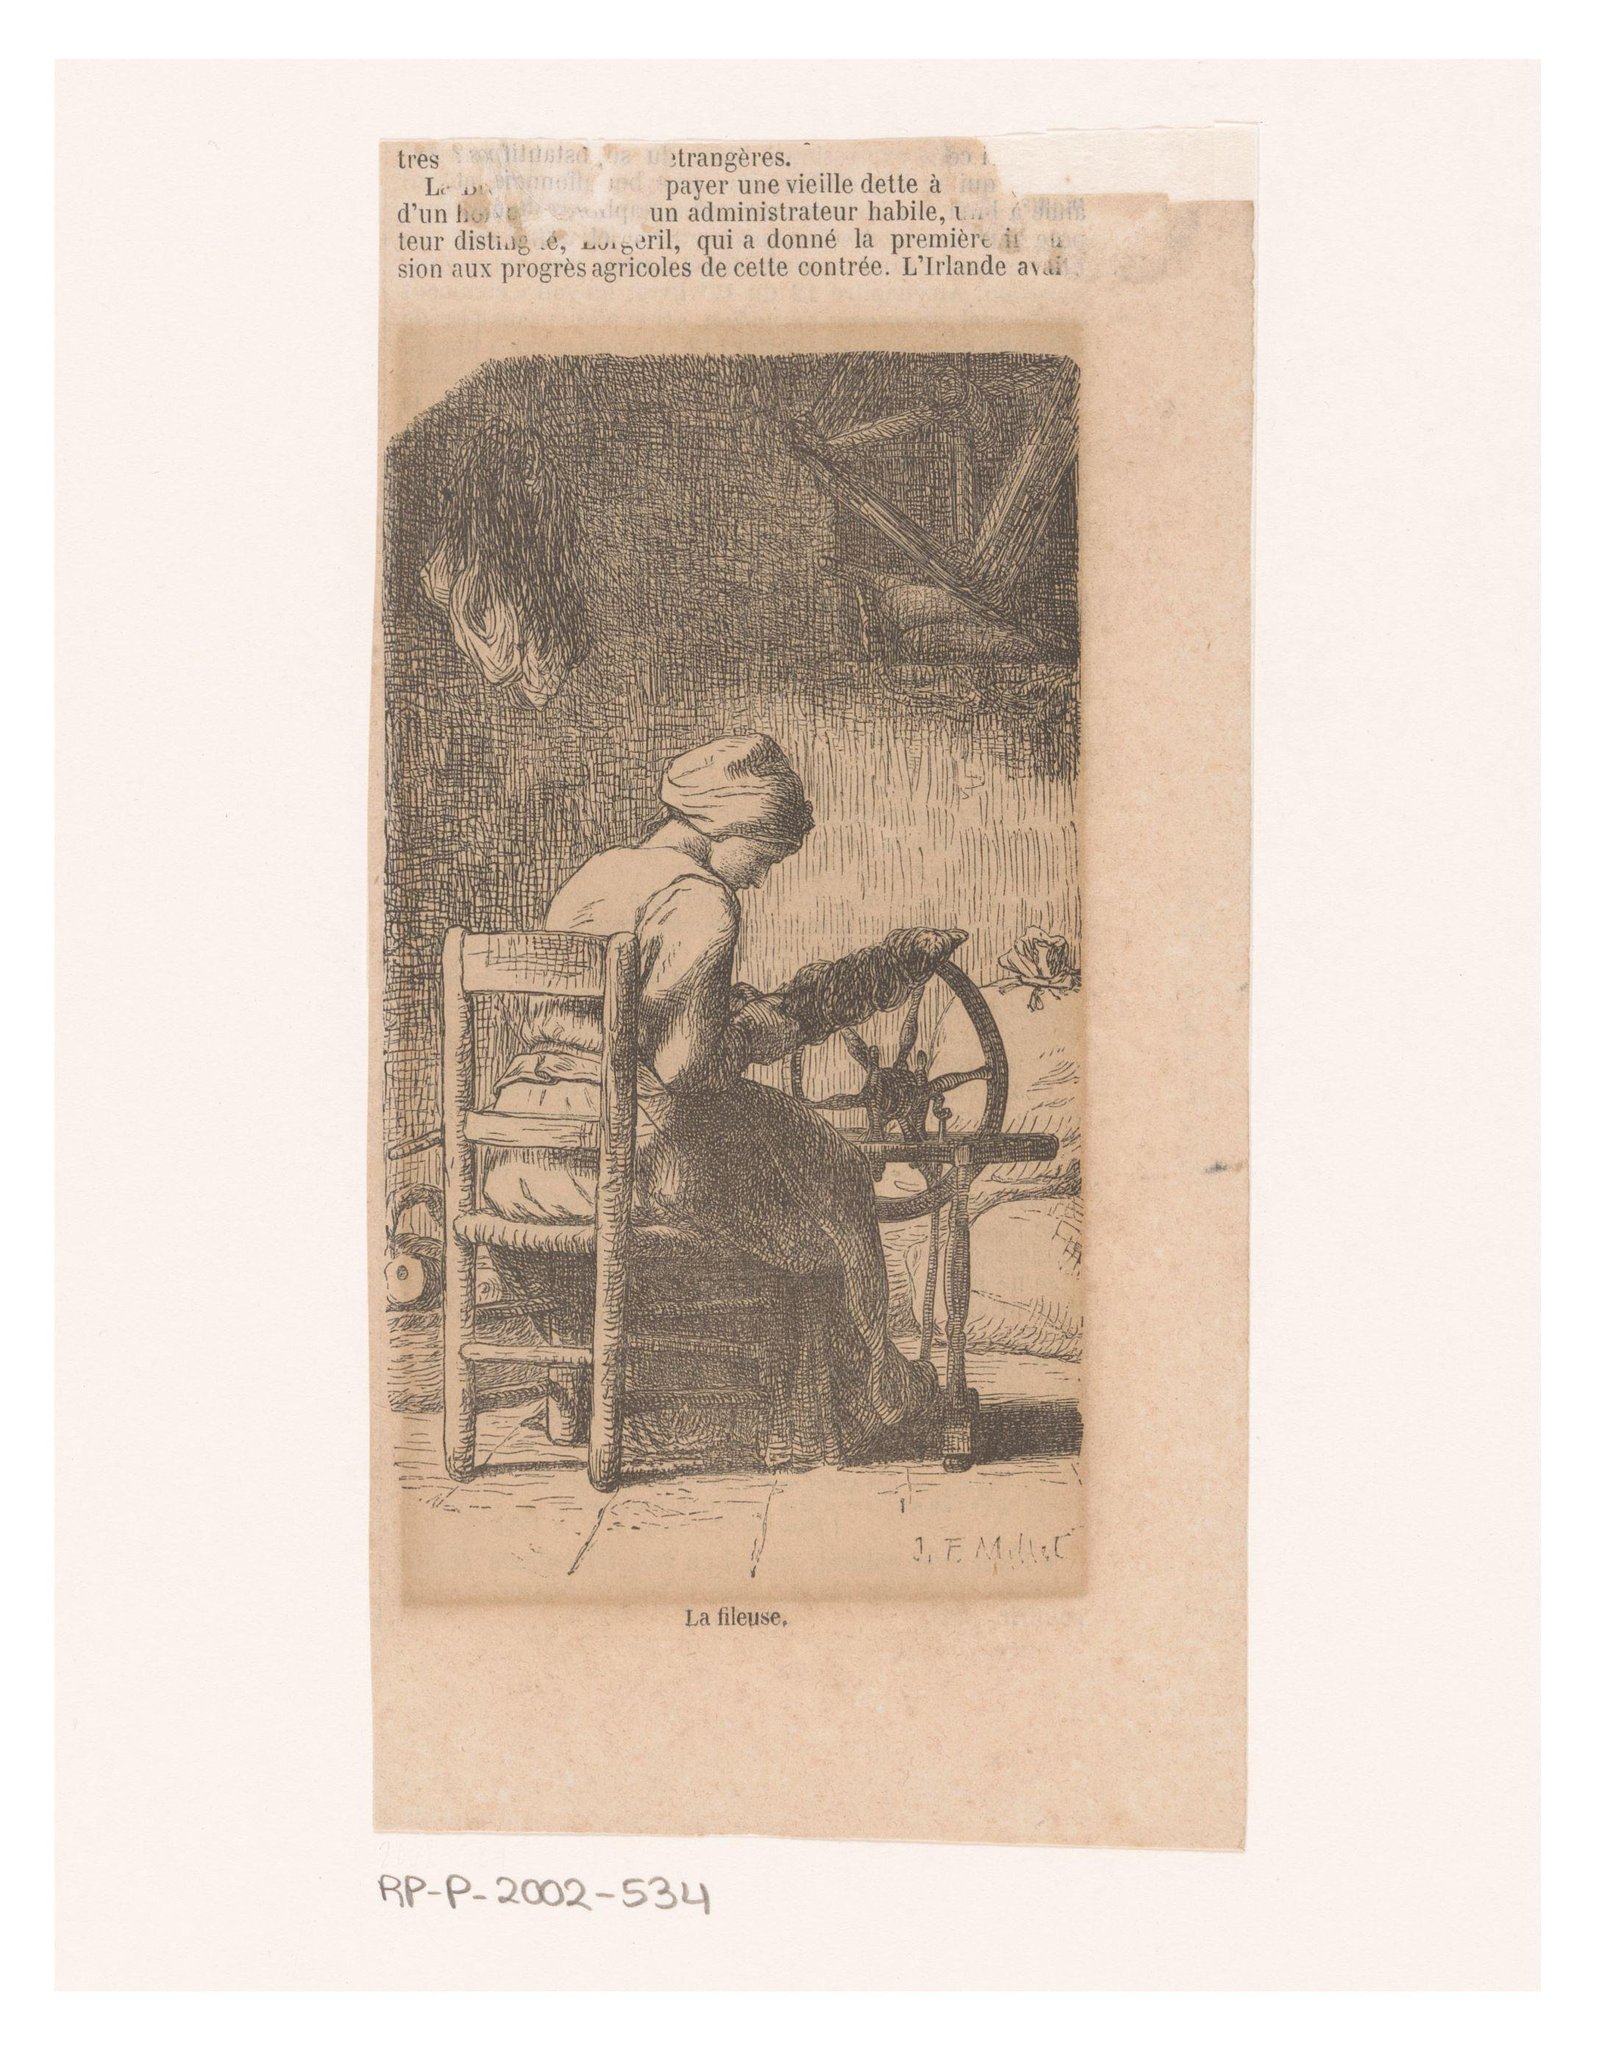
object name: print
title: Boerenwerk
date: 1853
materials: paper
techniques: letterpress printing, engraving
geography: paris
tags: crafts and industries (+ agricultural processes), spinning-wheel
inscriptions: collector's mark: Lugt 2228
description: Prent maakt deel uit van een serie van tien houtgravures gepubliceerd in 'L'Illustration' van 5 februari 1853, bij het artikel Revue Agricole van Saint-Germain Leduc.